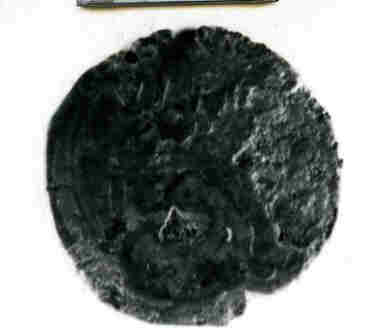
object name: coin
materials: copper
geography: iran